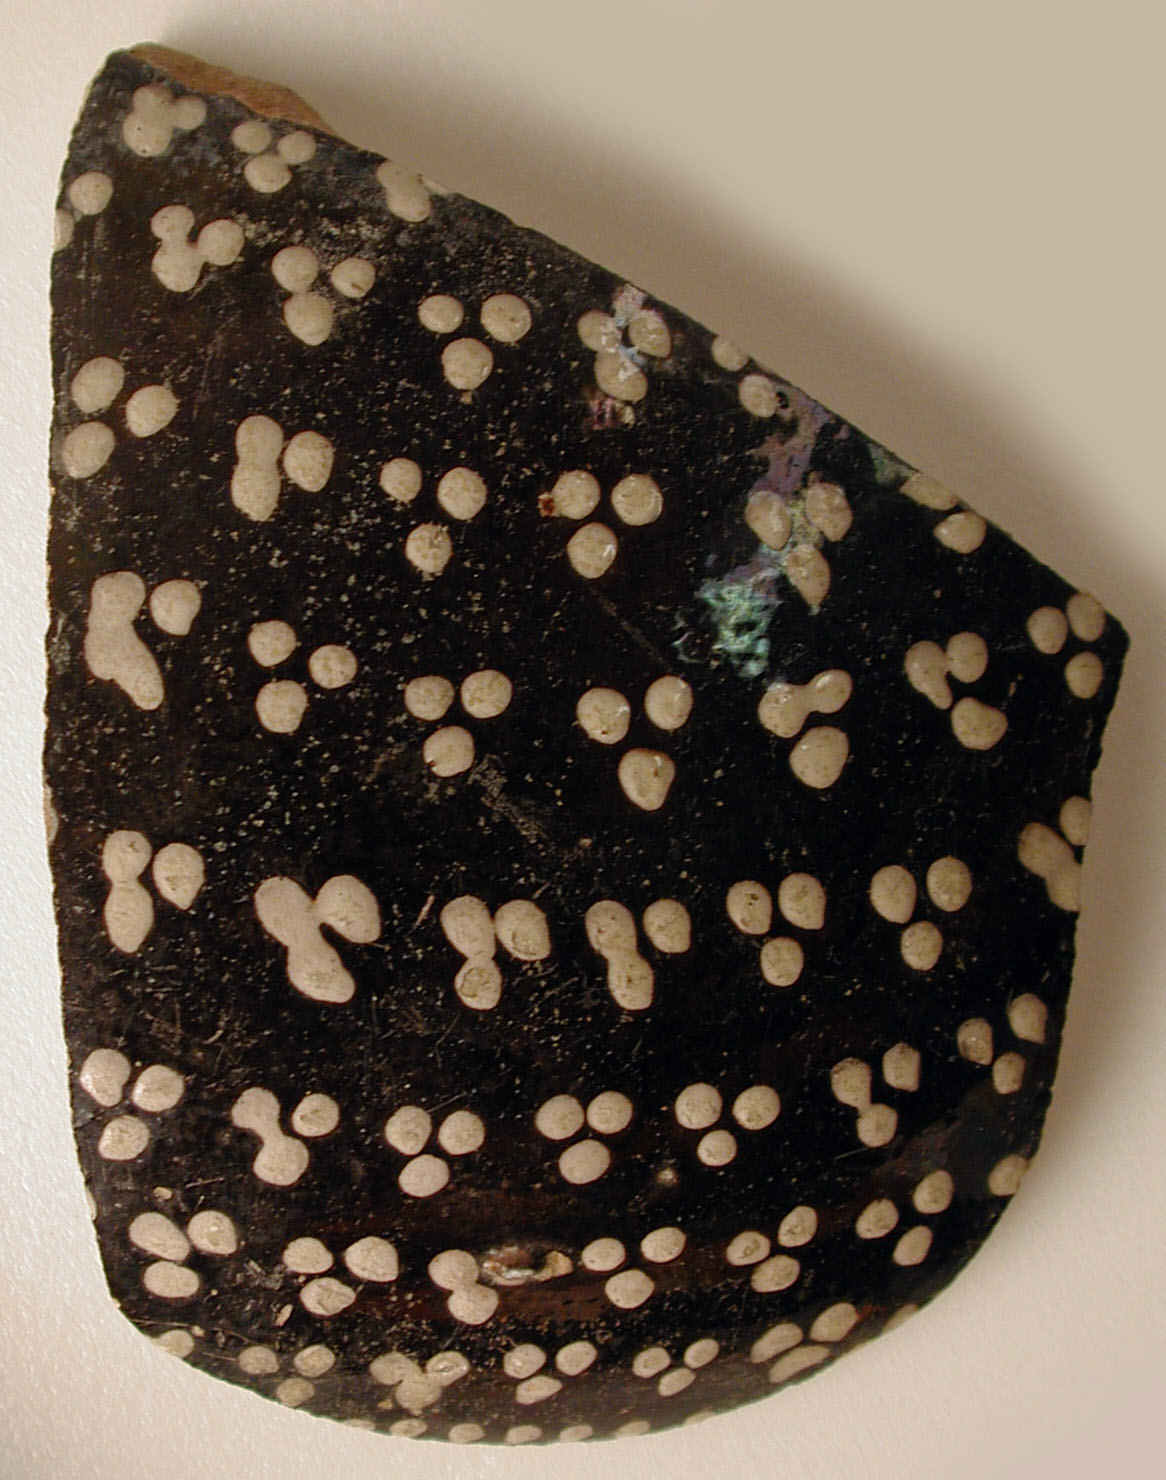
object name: fragment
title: Fragment with Clusters of White Dots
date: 801-1100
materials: earthenware, glaze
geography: uzbekistan